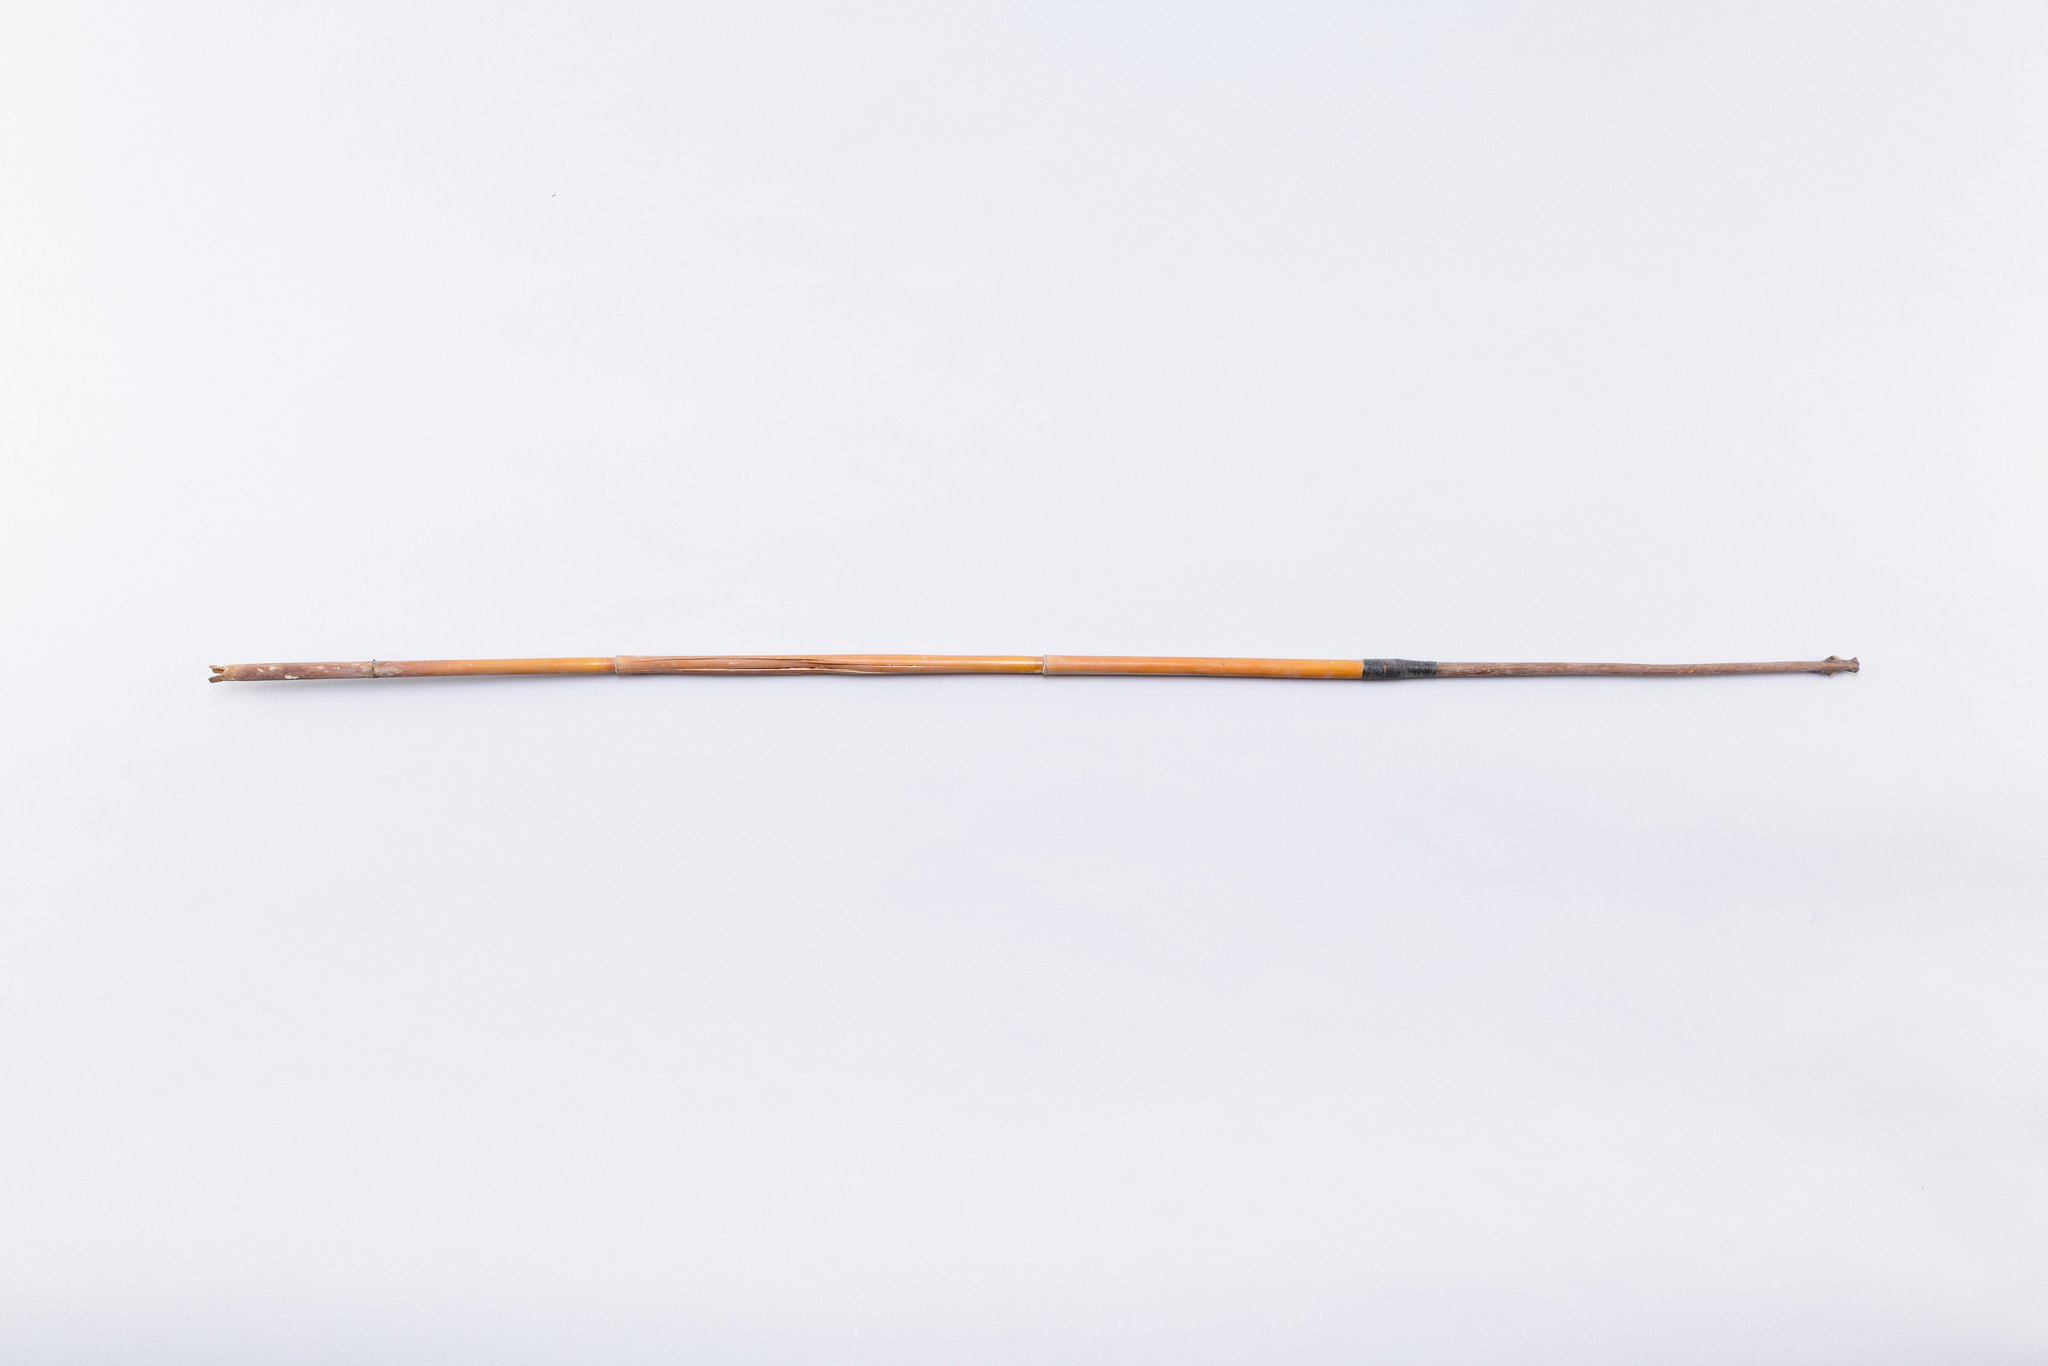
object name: arrow, arrowhead, adhesive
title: Arrow with composite stone tip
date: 1479-1458 BCE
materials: quartz, wood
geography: egypt